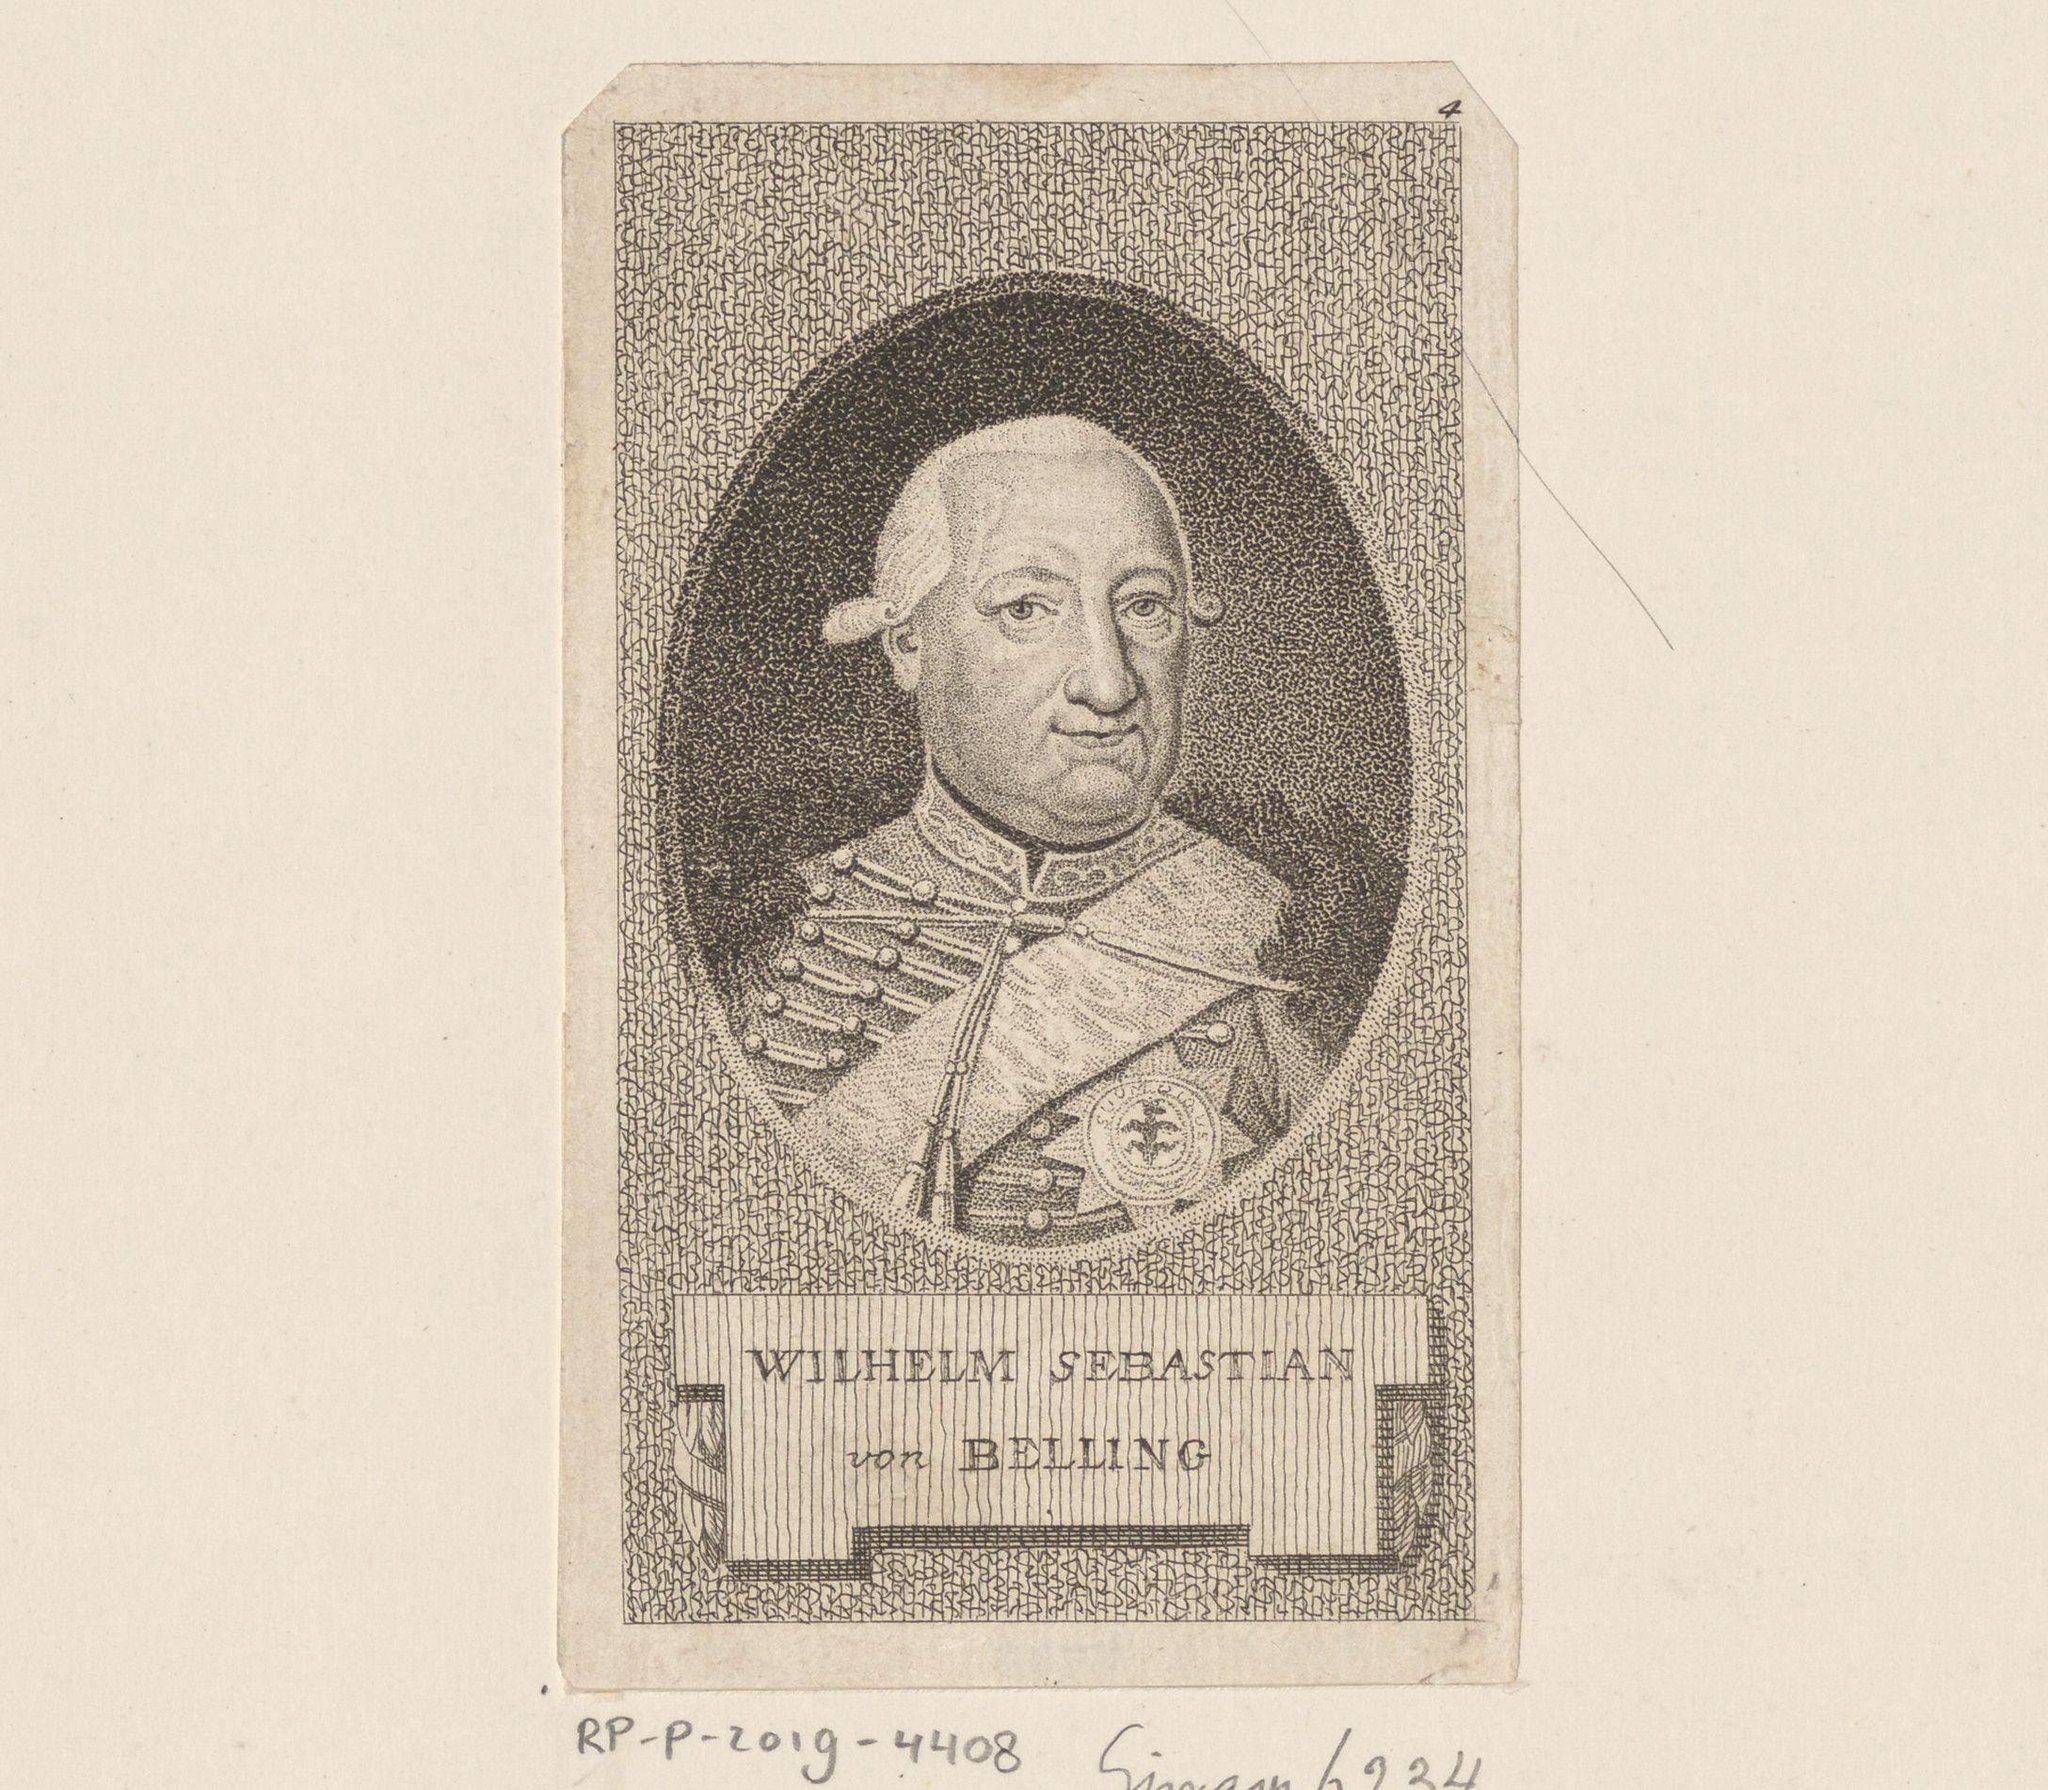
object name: print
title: Portret van Wilhelm Sebastian von Belling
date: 1750-1799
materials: paper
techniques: etching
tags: historical persons